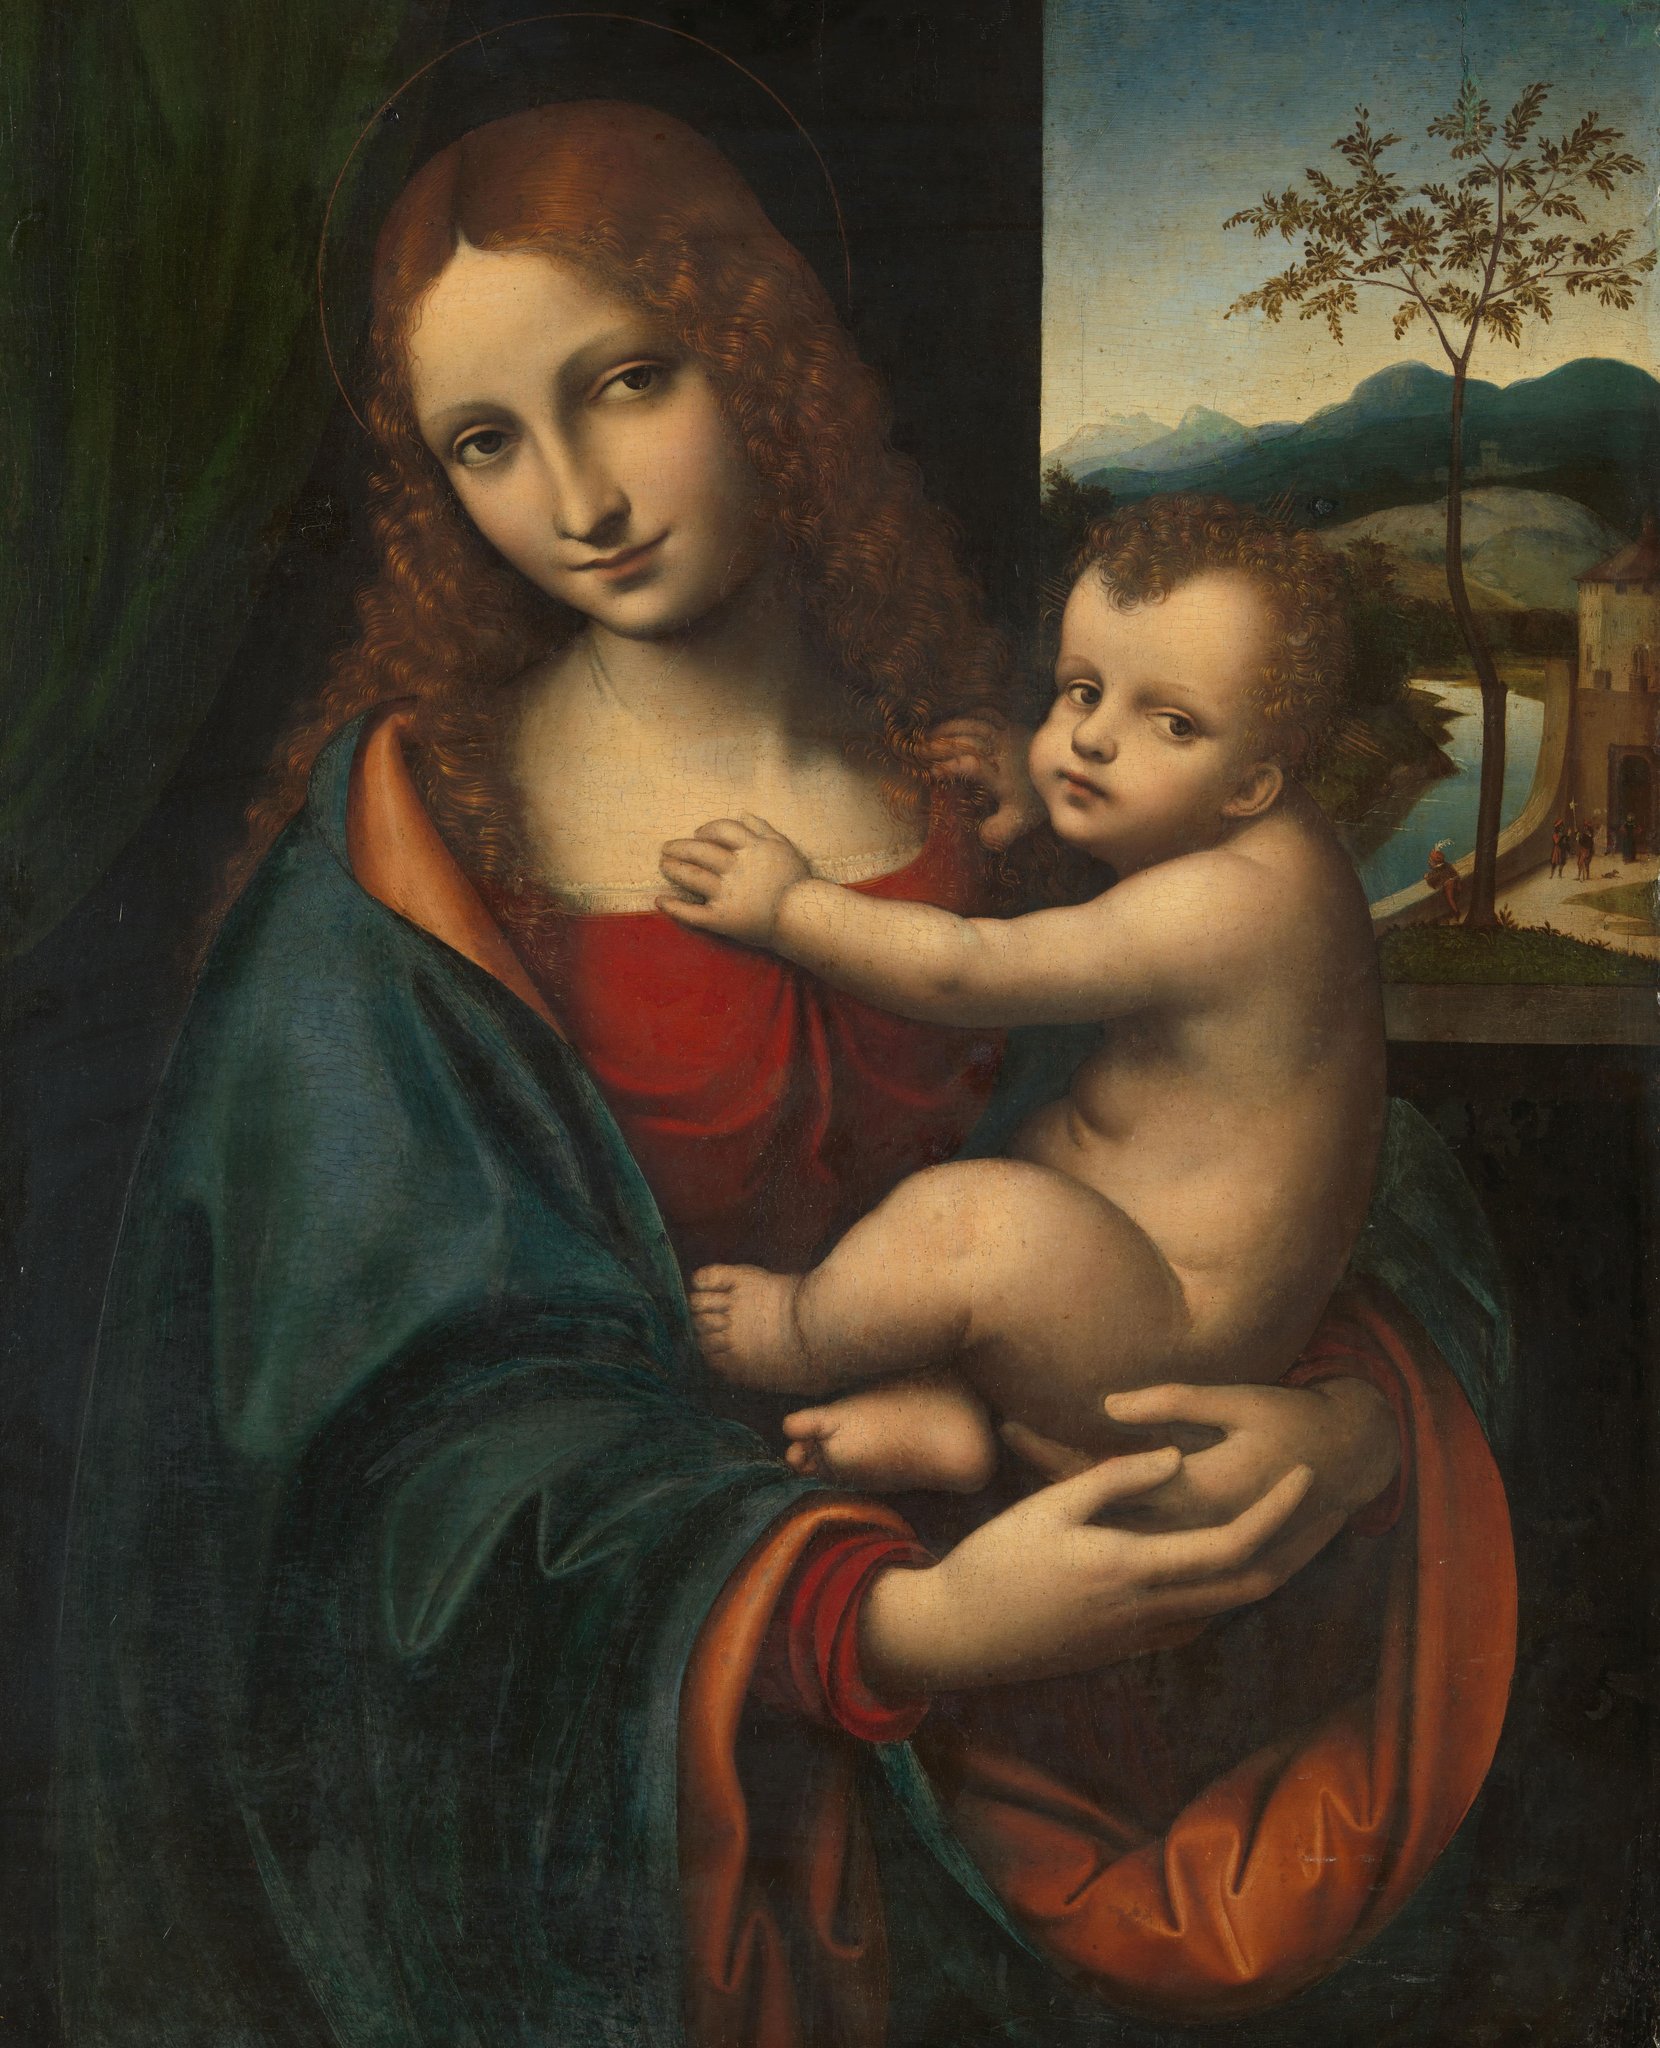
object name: painting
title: Madonna and Child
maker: giampetrino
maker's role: painter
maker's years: 1495-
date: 1510-1525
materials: oil, paint, panel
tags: mary standing (or half-length), the christ-child on her arm (christ-child to mary's left)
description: Maria met het Christuskind op de armen. Staand, ten halven lijve, bij een venster met uitzicht op een landschap.